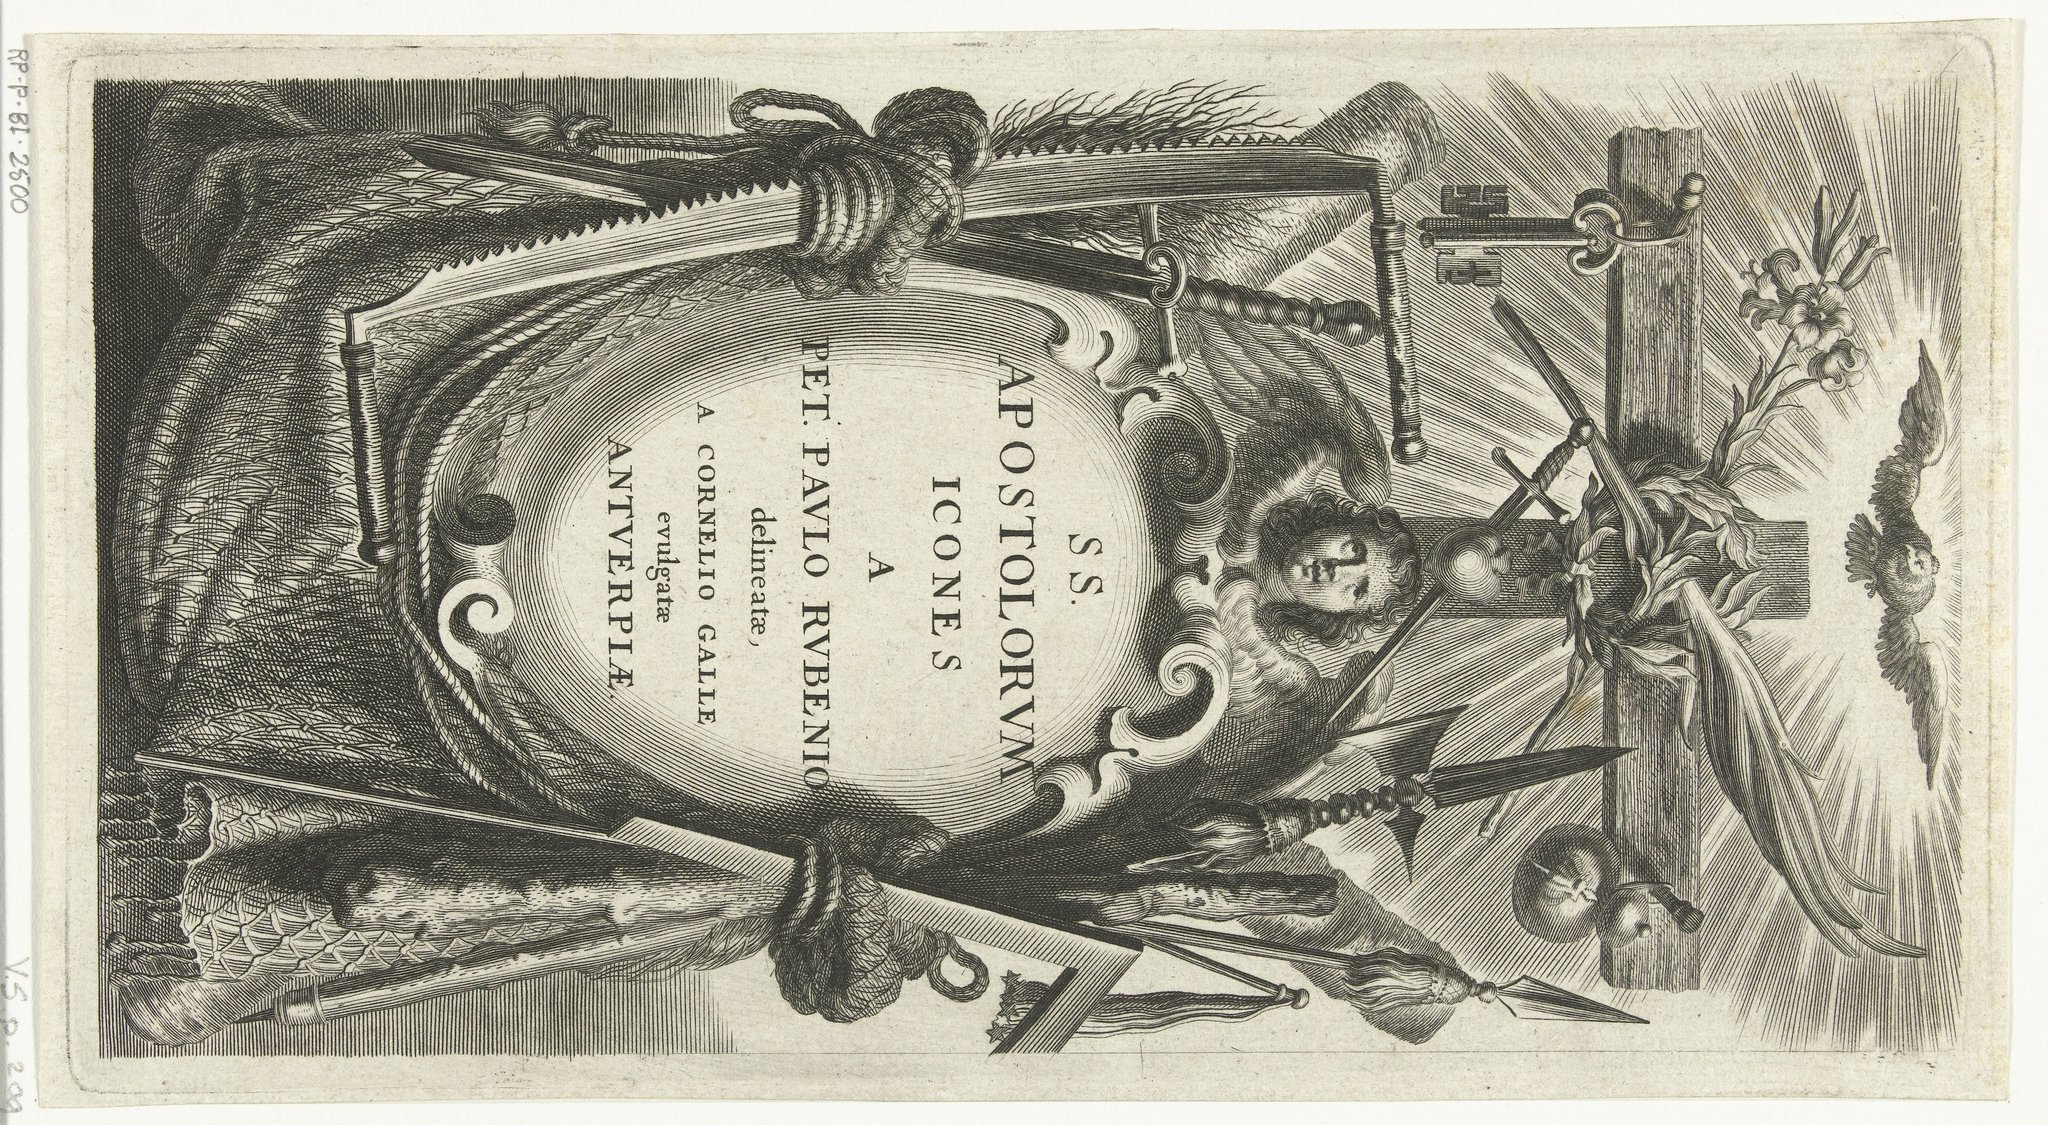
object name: print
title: SS. Apostolorum Icones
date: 1596-1659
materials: paper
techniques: engraving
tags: key, the cross ~ symbols of christ, casting weapons: spear, tools, aids, implements ~ crafts and industries: saw, holy ghost represented as a dove (in flames)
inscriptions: collector's mark: Lugt 240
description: Titelprent voor: SS. Apostolorum Icones, Cornelis Galle (uitgever) Antwerpen. Serie van vijftien prenten naar ontwerp van Peter Paul Rubens met titelprent, Christus, Maria en de twaalf apostelen.